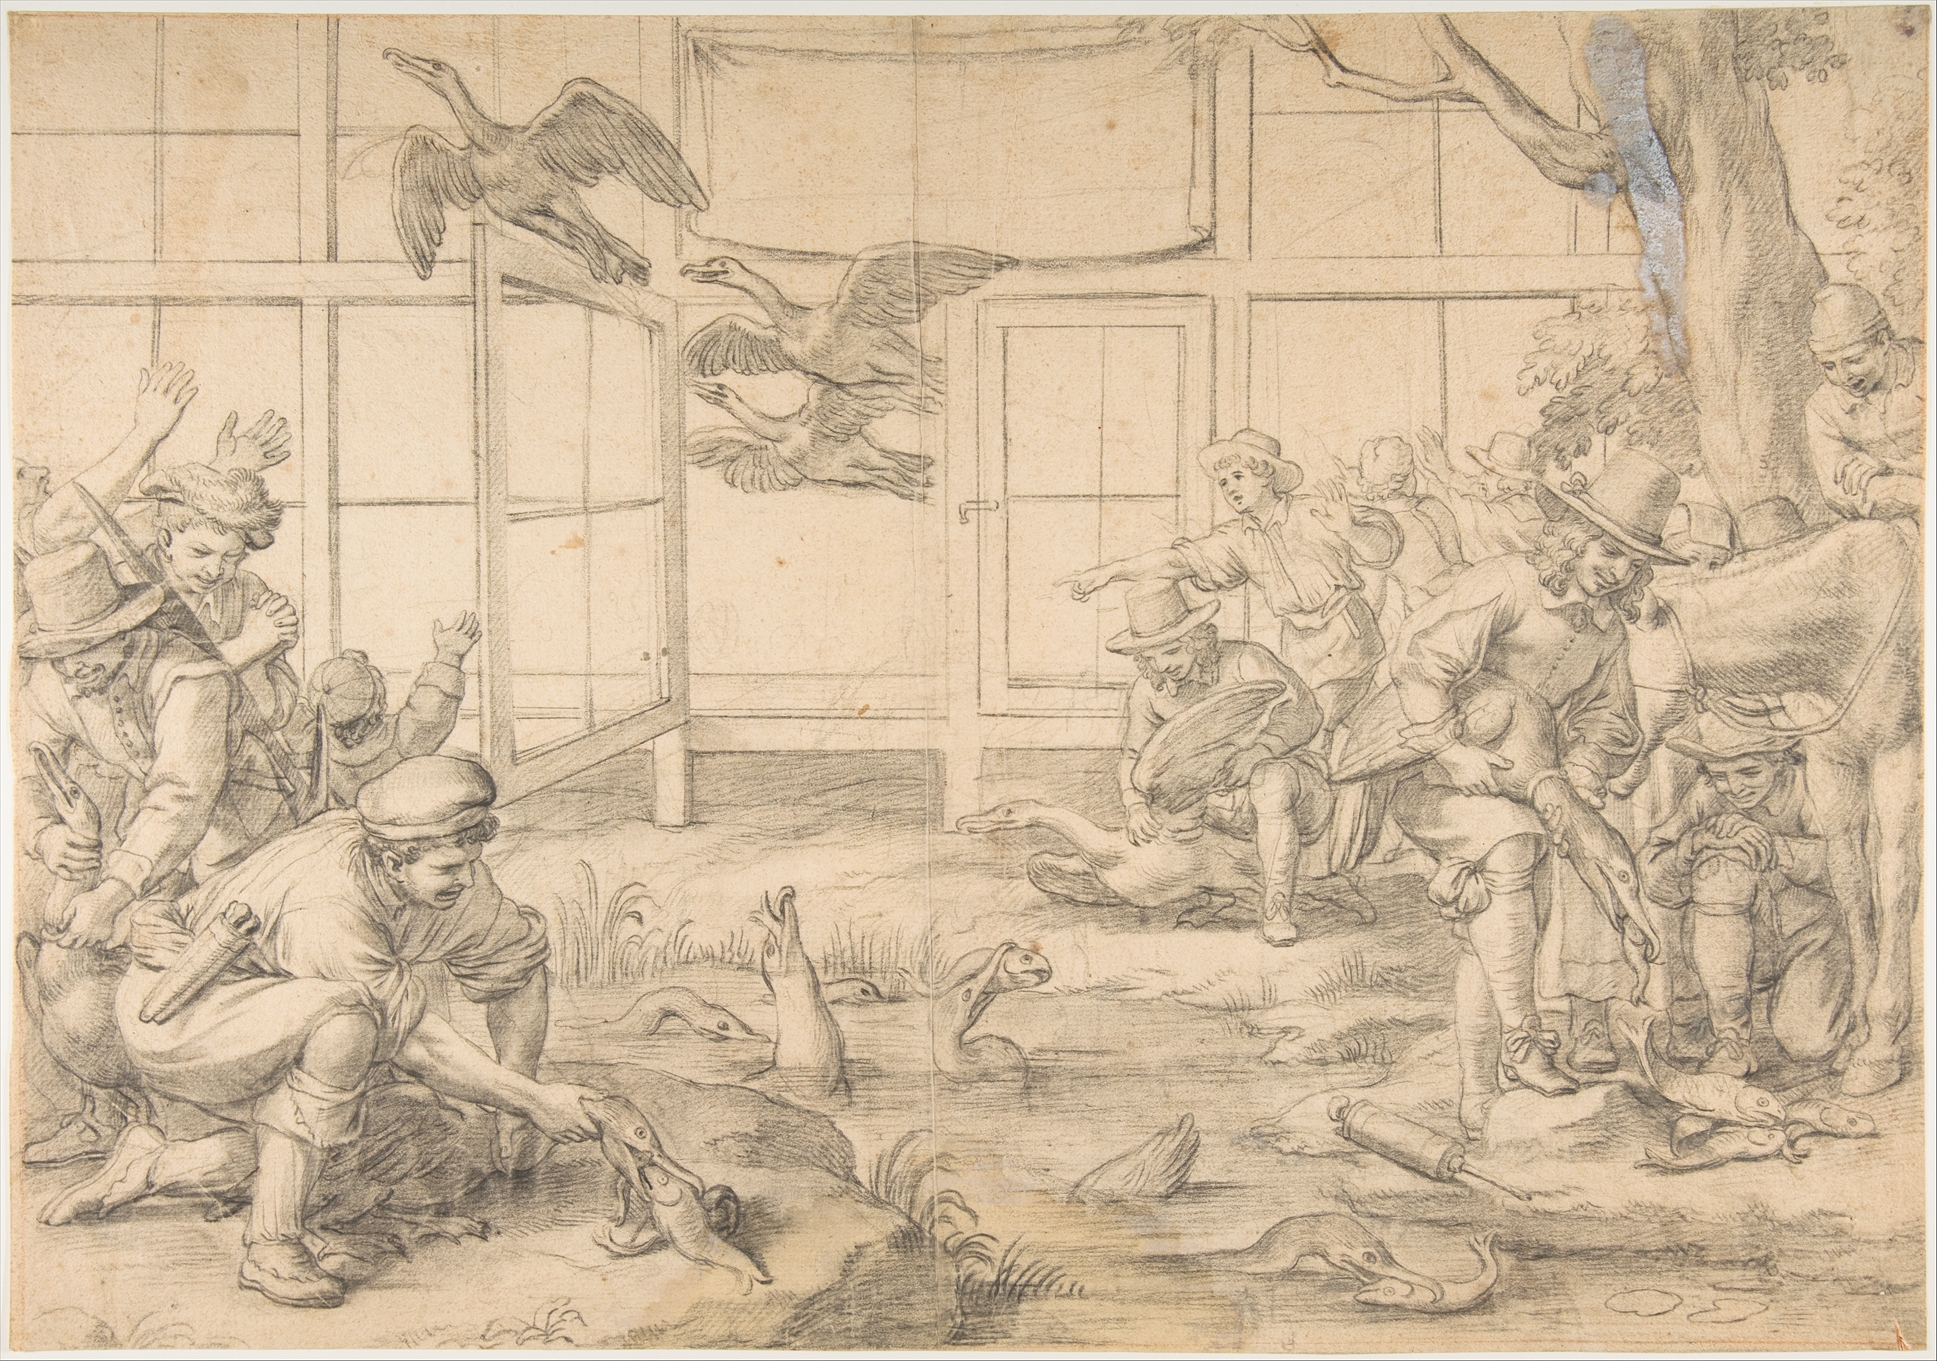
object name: drawing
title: The Defeat of the Cormorants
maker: louis testelin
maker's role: artist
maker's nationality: french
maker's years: 1615-1655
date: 1648-1653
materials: chalk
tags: birds,men,fish